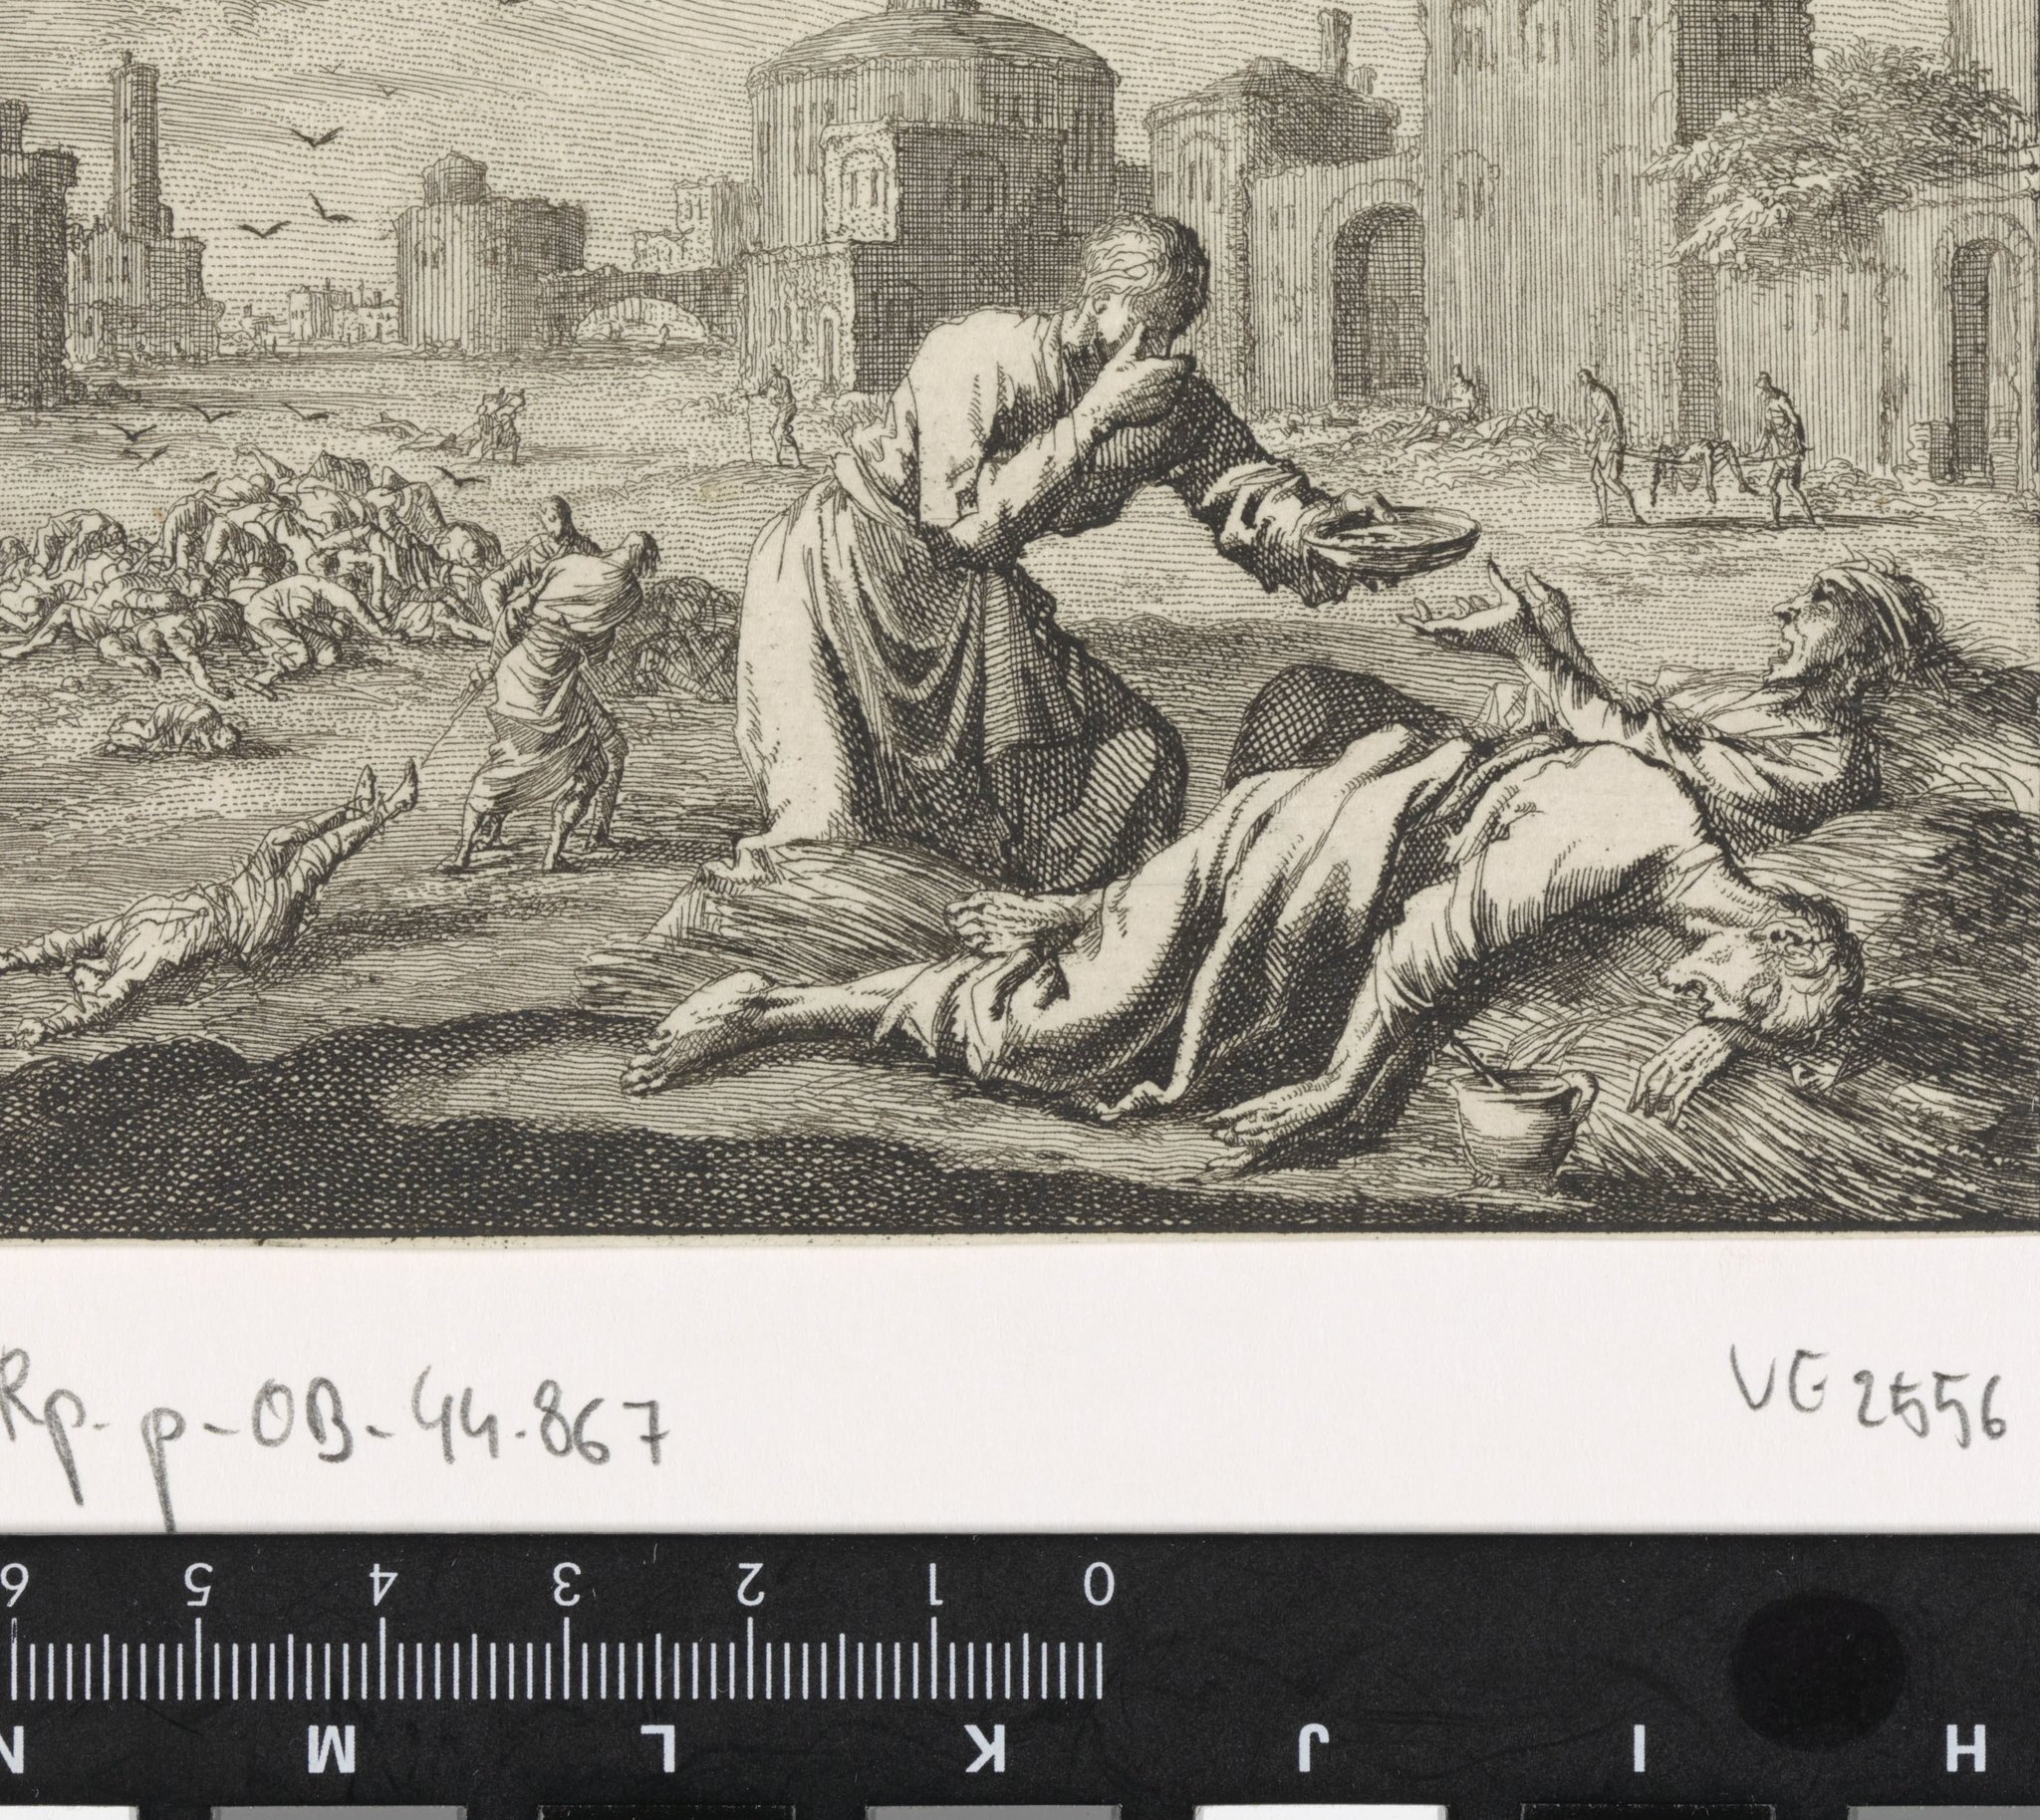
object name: print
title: Embleem: pest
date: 1695-1705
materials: paper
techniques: etching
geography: amsterdam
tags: street, nursing, tending the sick, plague, abstract ideas and concepts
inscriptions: collector's mark: Lugt 240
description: Boekillustratie voor Weigel, Christoph. Ethica Naturalis seu Documenta Moralia e Variis rerum Naturalium proprietatibus Virtutum Vitiorumq symbolicis imaginibus collecta. Neurenberg: Christoph Weigel: c. 1700.